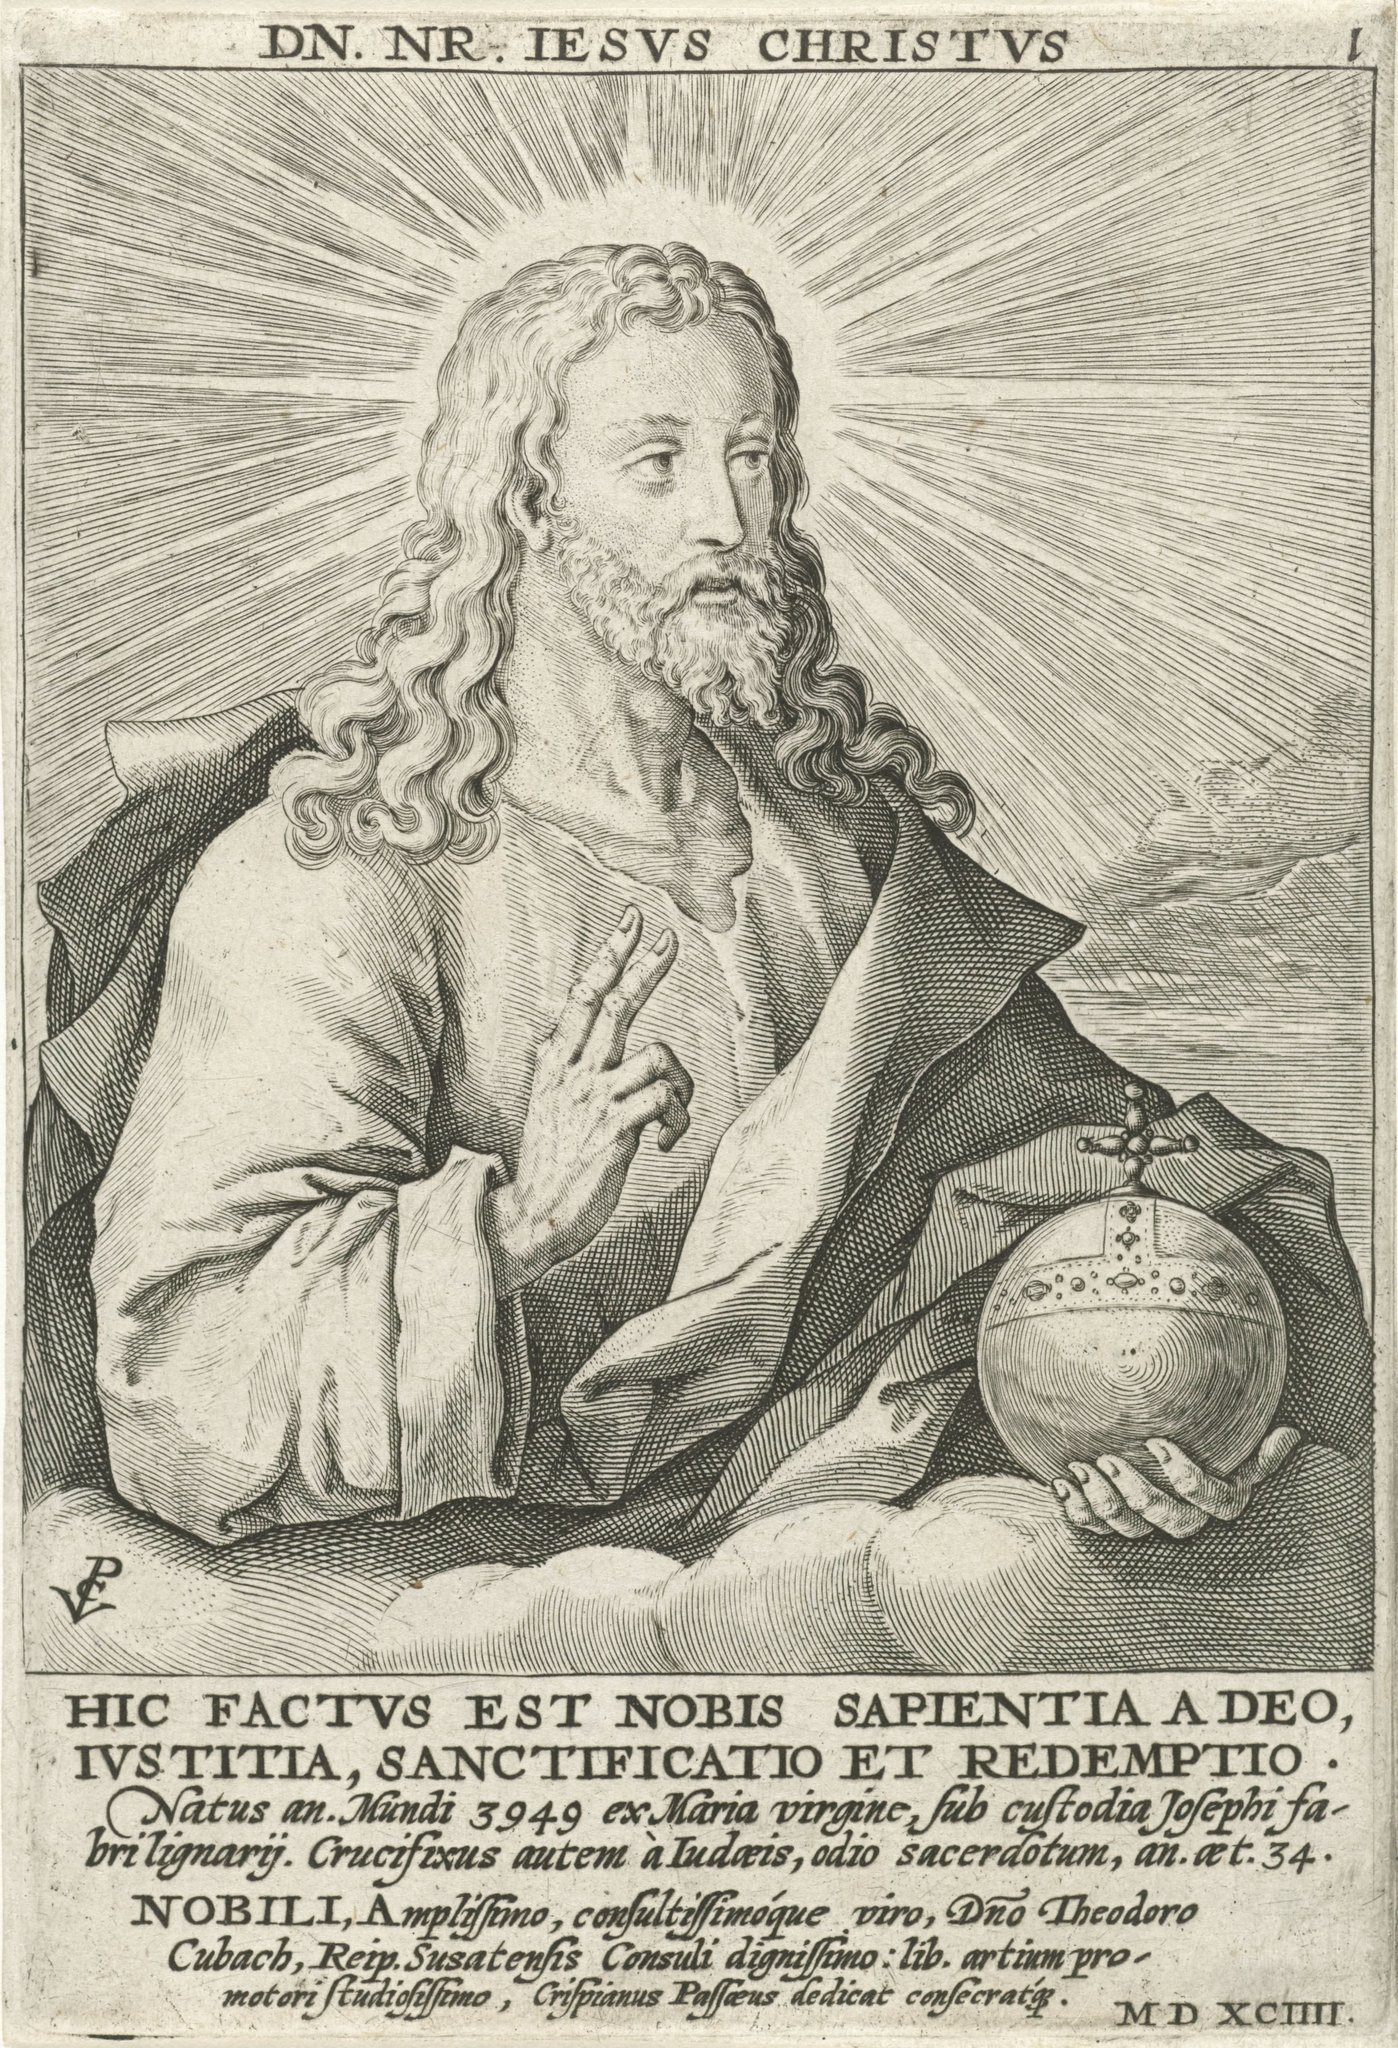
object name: print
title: Christus als Salvator Mundi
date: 1594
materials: paper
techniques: engraving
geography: cologne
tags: 'salvator mundi', making a blessing gesture; an orb in his hand or at his feet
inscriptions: collector's mark: Lugt 2228, collector's mark: Lugt 2542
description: Christus houdt een rijksappel in zijn linkerhand en maakt een zegenend gebaar met zijn rechterhand. In de marge een onderschrift over het leven en de dood van Christus en een onderschrift met een opdracht, in het Latijn. Titelprent uit een serie met Christus en de apostelen.